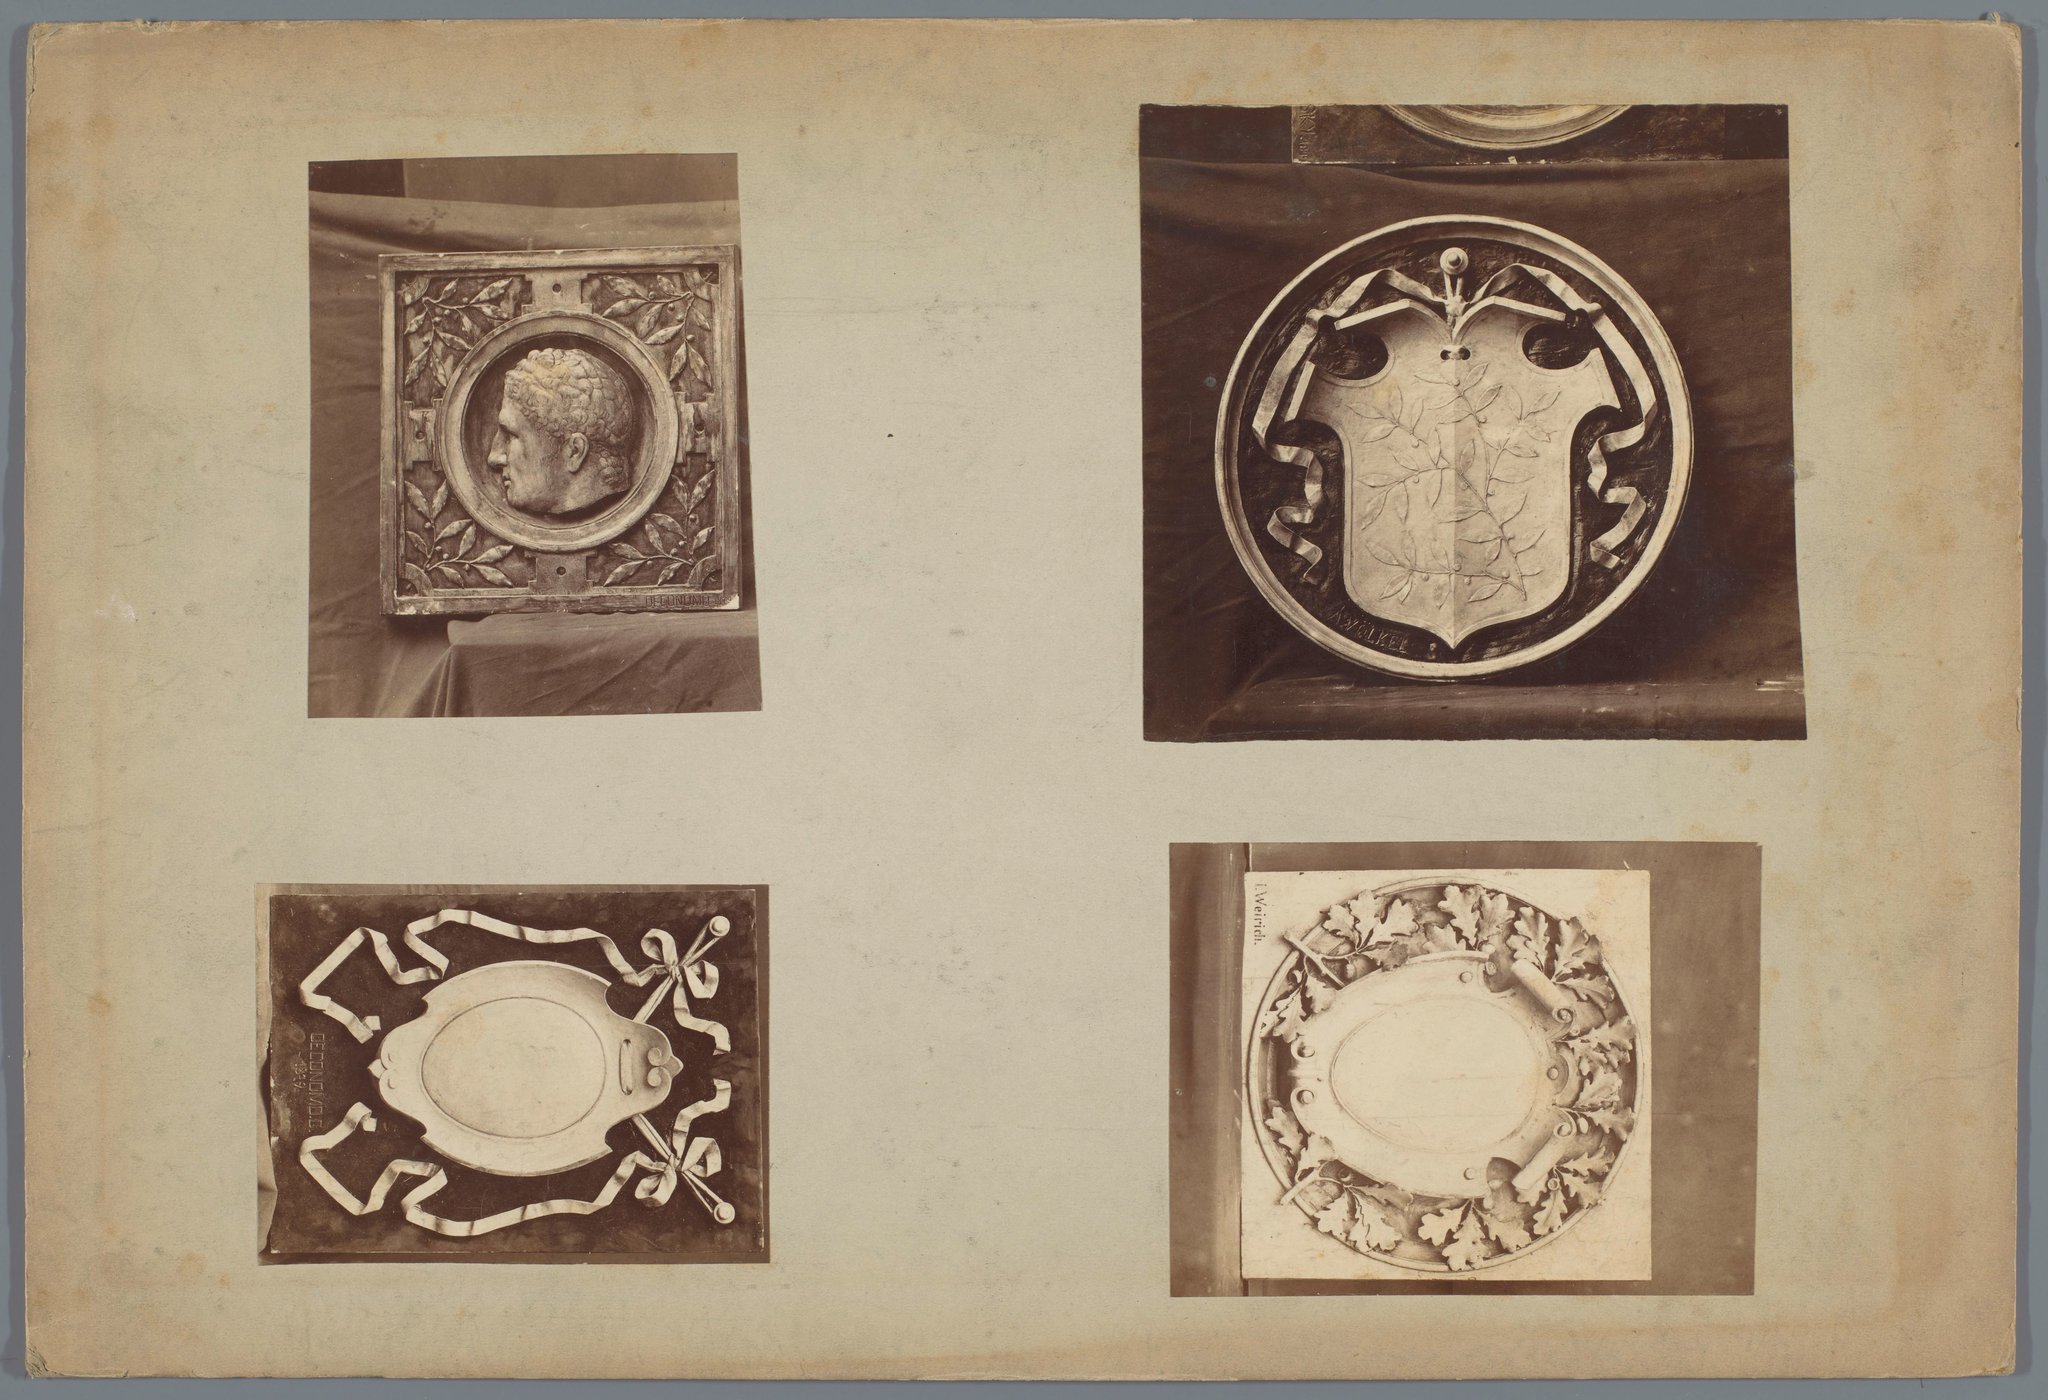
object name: photograph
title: Overzicht van vier reliëfs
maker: Anonymous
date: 1879-1900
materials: cardboard, photographic support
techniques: albumen print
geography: europe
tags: anonymous historical person portrayed (+ profile portrait), ornament ~ cartouche, armorial bearing, heraldry, sculpture (+ relief ~ sculpture), europe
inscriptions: collector's mark: Lugt 3937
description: Linksboven een mannengezicht en profil, rechtsboven een wapenschild, linksonder een cartouche en rechtsonder een cartouche met eikenbladeren.